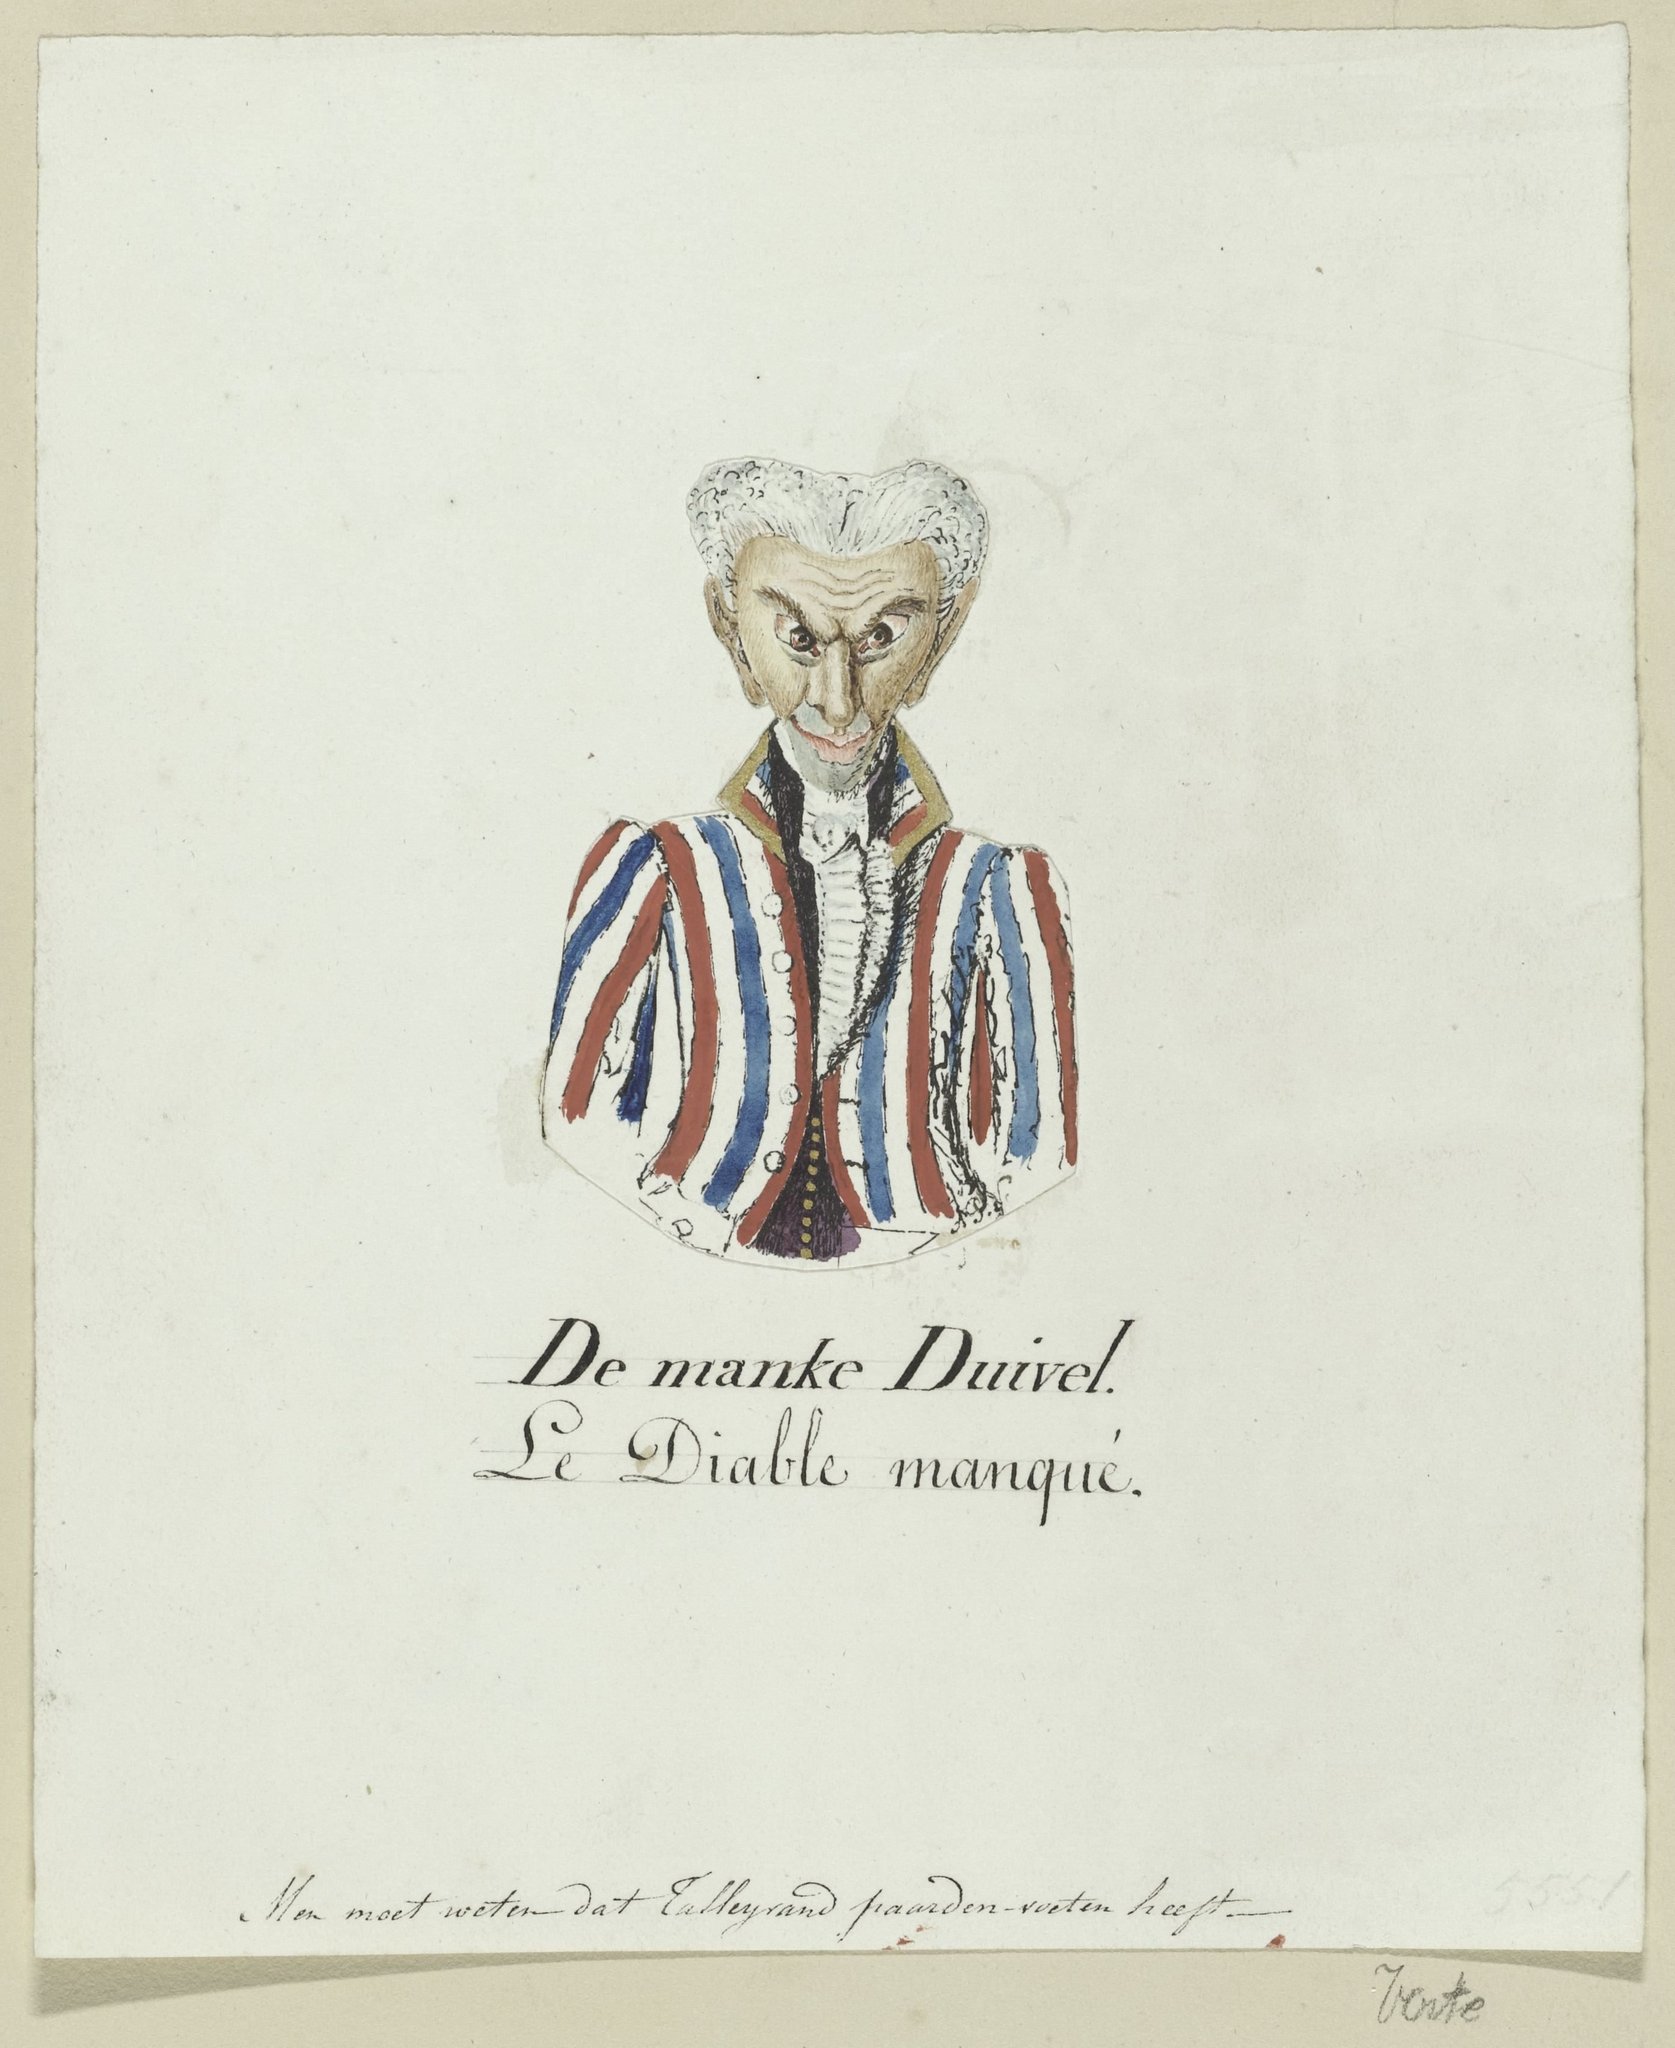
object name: cartoon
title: Karikatuur van Talleyrand, 1832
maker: Anonymous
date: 1832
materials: paper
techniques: hand coloring, lithograph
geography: netherlands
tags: paris, politician, charles maurice hertog van talleyrand-périgord, caricatures (human types)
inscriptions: collector's mark: Lugt 2228, inscription: ‘Men moet weten dat Talleyrand paarden-voeten [horrelvoeten] heeft.’, signature: ‘A.P.S [of] A.P. Sc.’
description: Spotprent op Charles-Maurice de Talleyrand, de Franse ambassadeur in Londen en deelnemer aan de onderhandelingen tijdens de Conferentie van Londen over de onafhankelijkheid van België, oktober 1832. Buste van Talleyrand uitgeknipt en opgeplakt. Op de achterzijde een deel van de grotere prent met dezelfde buste met wapen en vaandels (zie FMH 6848).